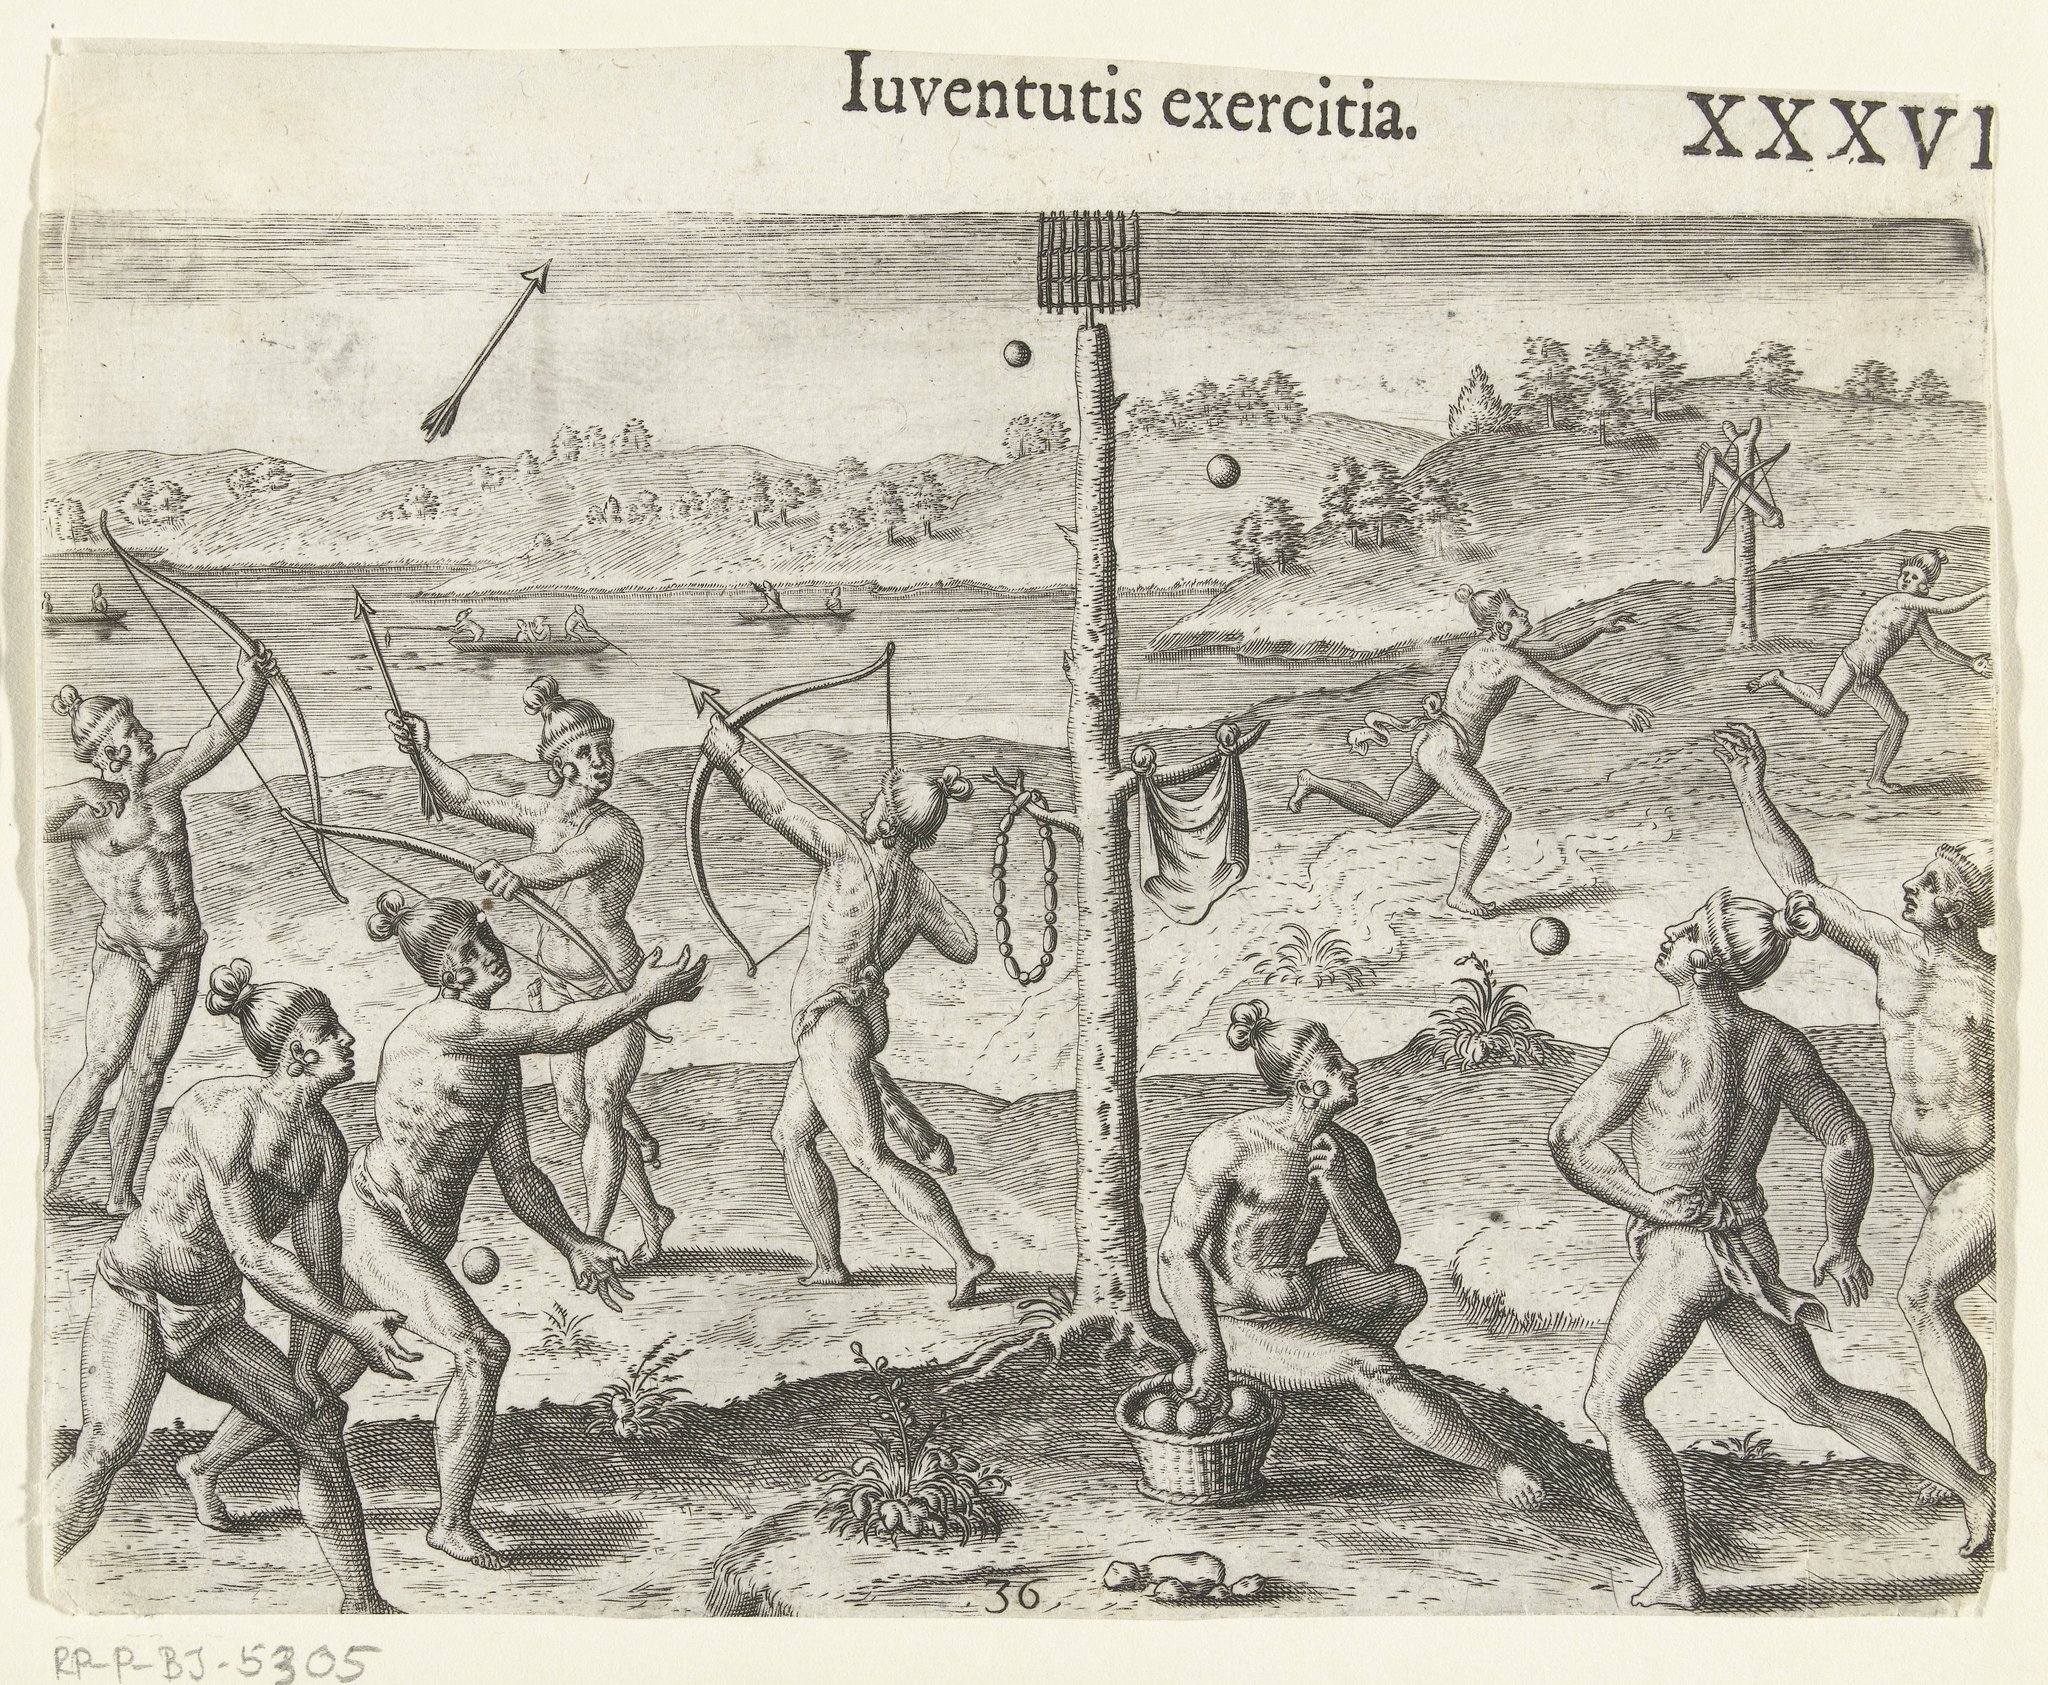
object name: book illustration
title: Schietoefeningen van de jeugd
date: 1591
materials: paper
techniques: engraving, letterpress printing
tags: handling of weapons ~ military training, native peoples of the americas, shooting with bow and arrow, archery (~ games of skill)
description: Afkomstig uit: Collectiones peregrinationum in Indiam occidentalem, dl. 2: René de Laudonnière, Brevis narratio eorum quae in Florida Americae provincia Gallis acciderunt. Frankfurt am Main: J. Wechelus, 1591.